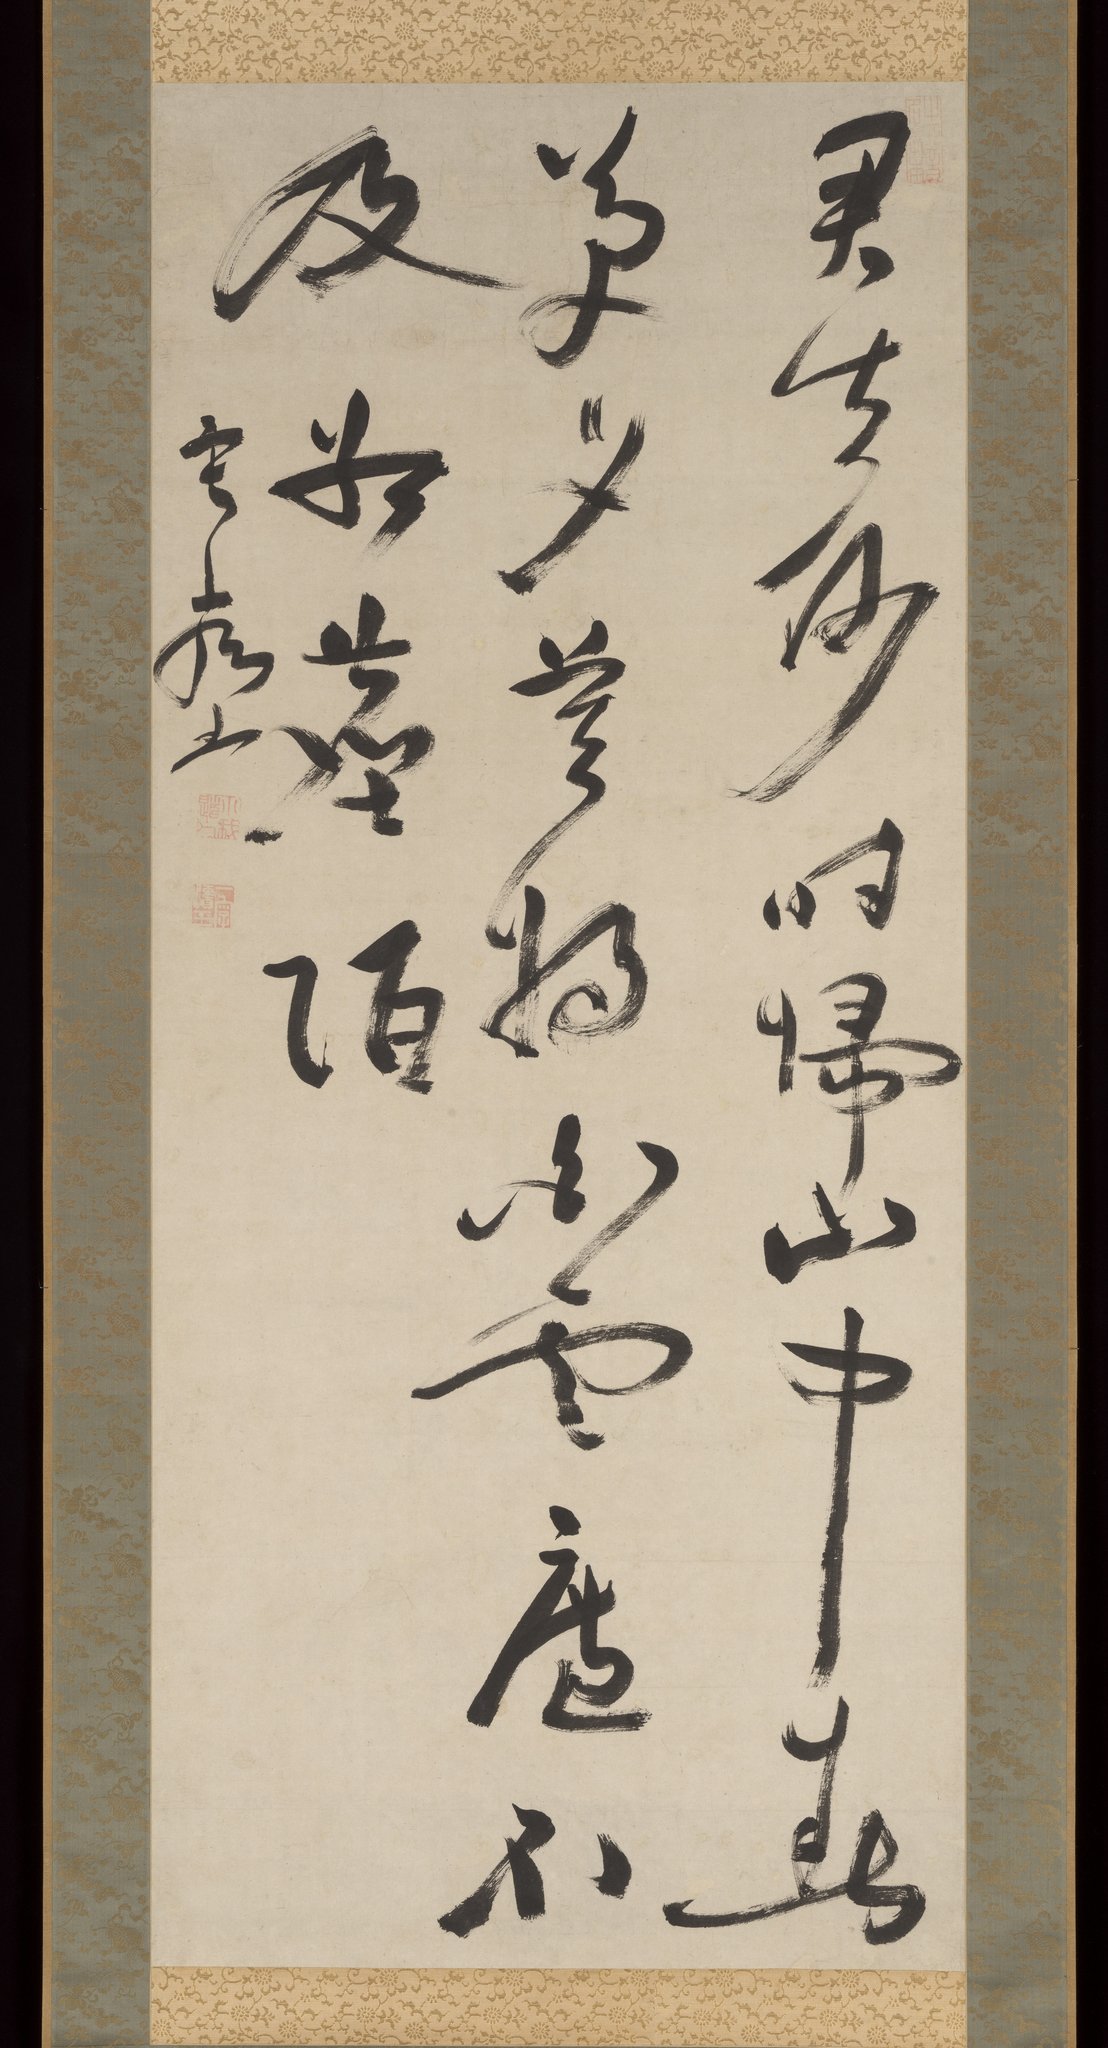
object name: hanging scroll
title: Chinese Poem Extolling a Reclusive Lifestyle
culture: japanese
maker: jakugon taijō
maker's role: artist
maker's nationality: japanese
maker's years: 1702-1771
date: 1734-1766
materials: ink, paper